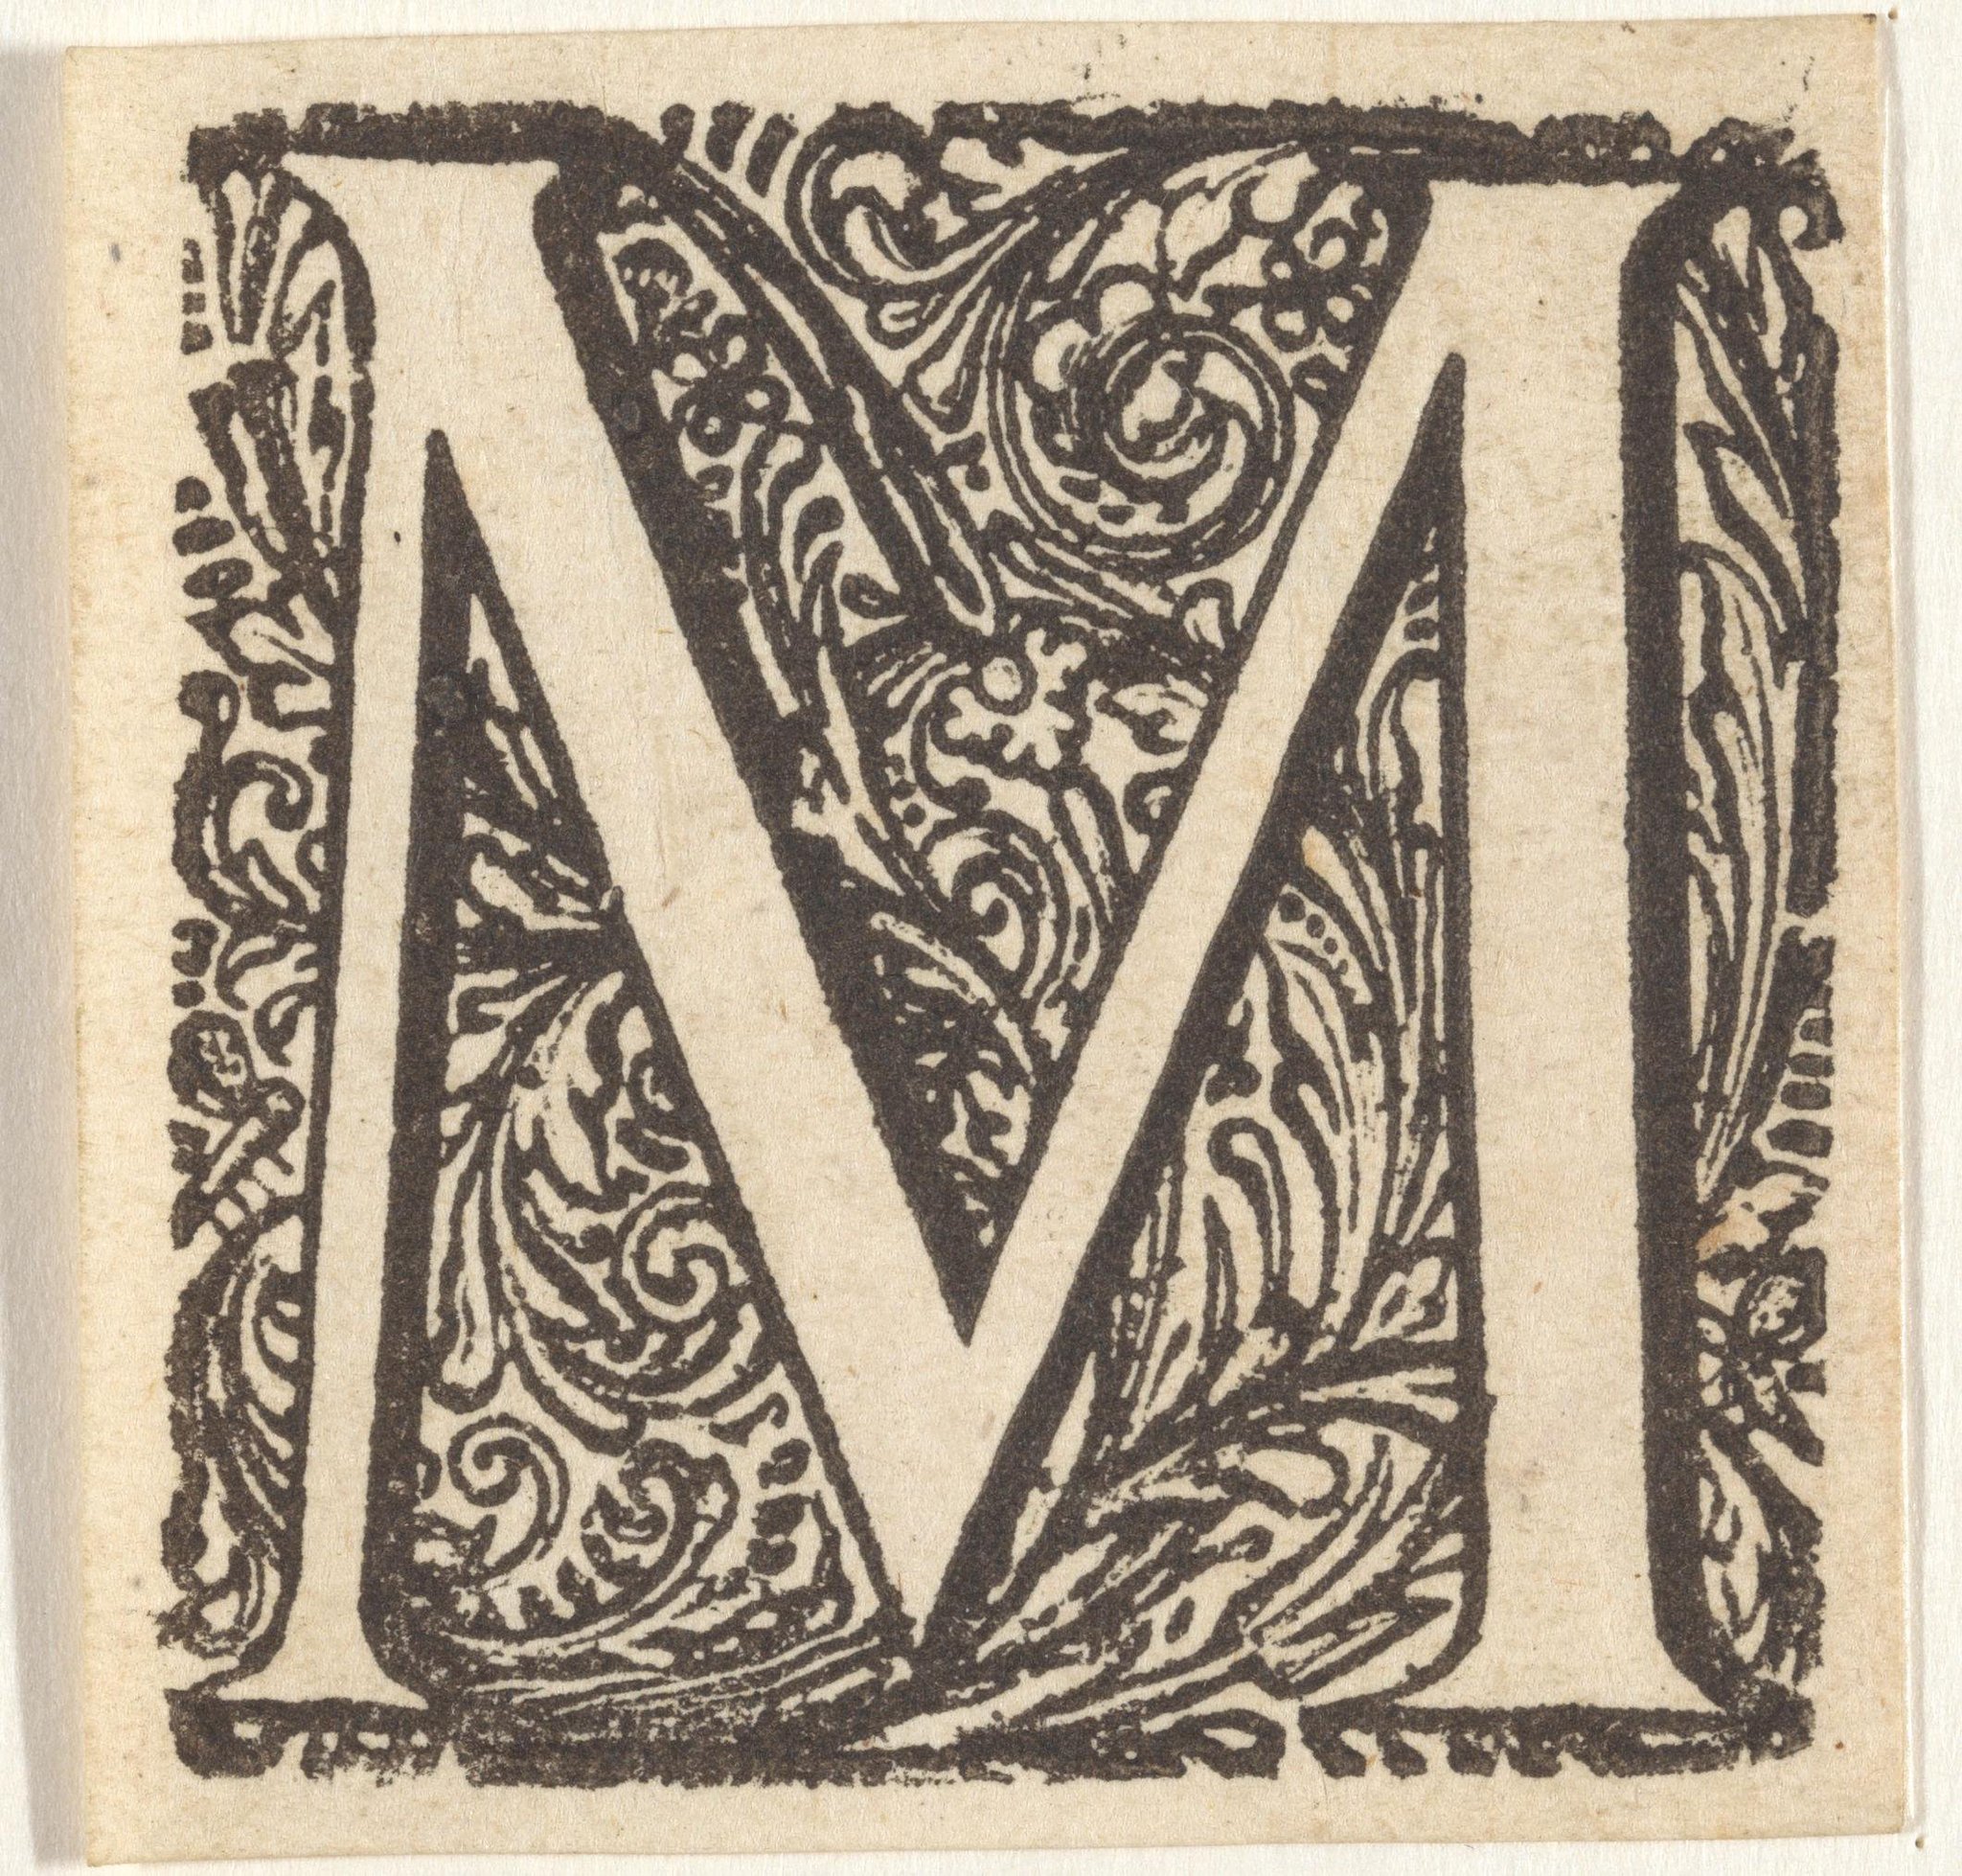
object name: print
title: Letter M in een geornamenteerde omlijsting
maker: Anonymous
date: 1600-1699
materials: paper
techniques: woodcut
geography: netherlands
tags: fancy letters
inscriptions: collector's mark: Lugt 240